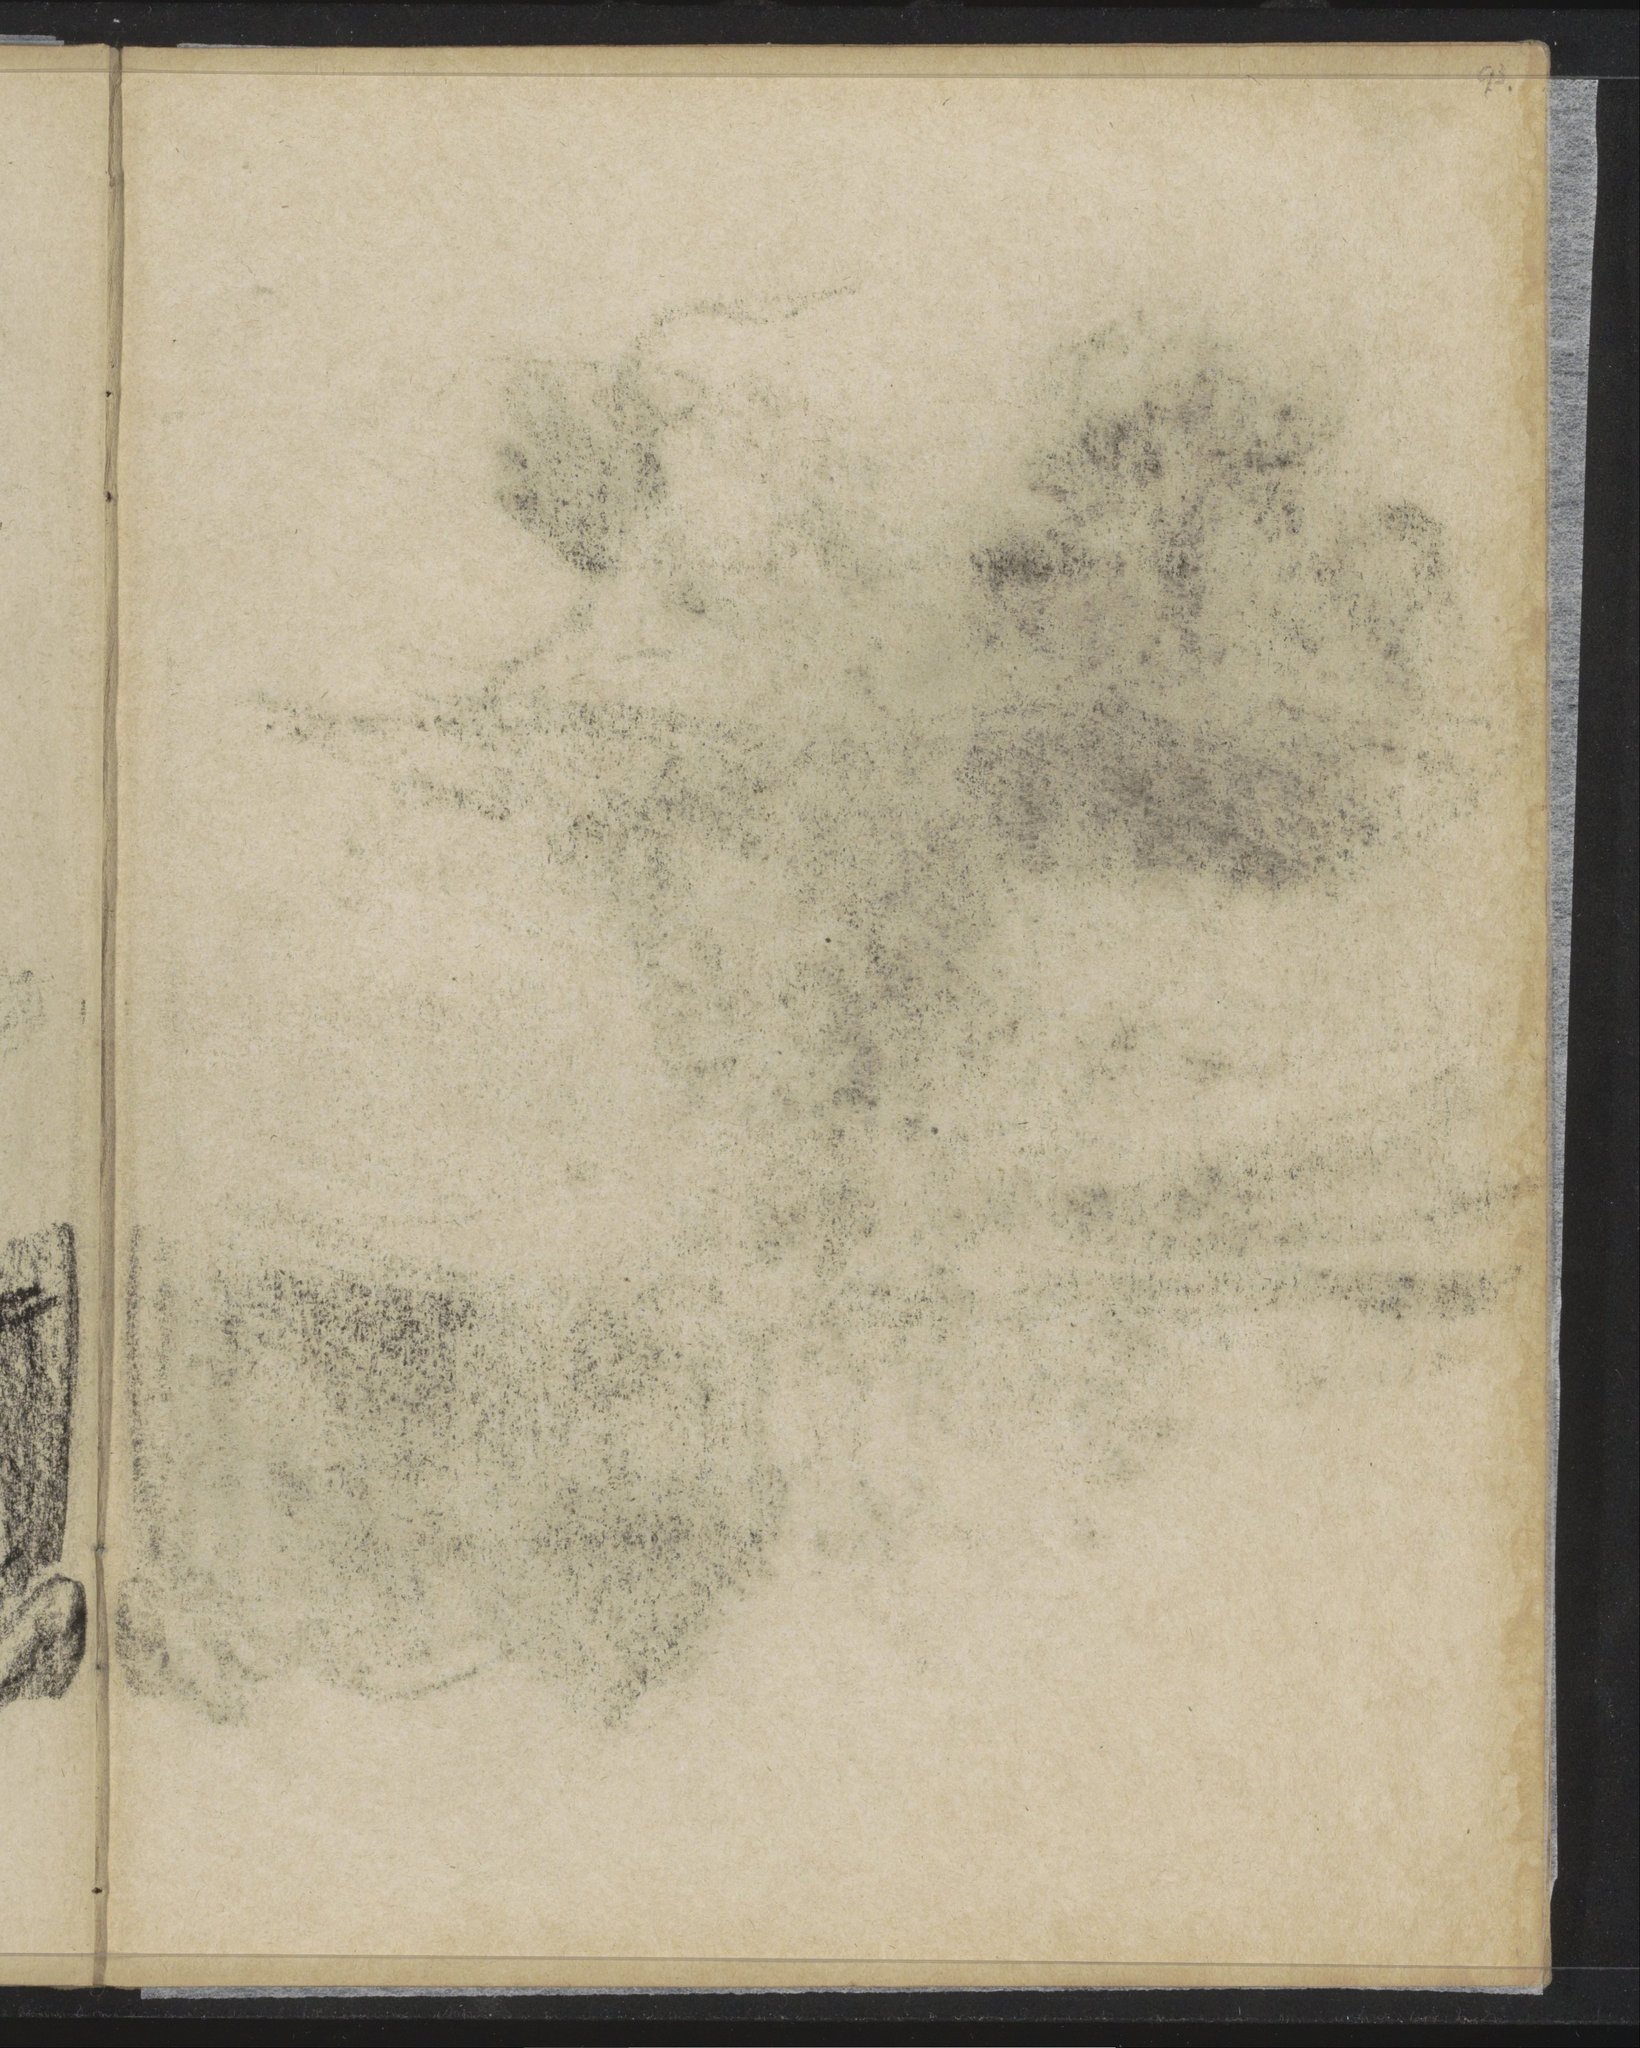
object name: sketchbook leaf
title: Abklatsch van de krijttekening op pagina 92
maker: willem witsen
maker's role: draughtsman, painter, print maker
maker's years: 1860-1923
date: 1884-1891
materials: paper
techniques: printmaking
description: Pagina 93 uit een schetsboek met 49 bladen.